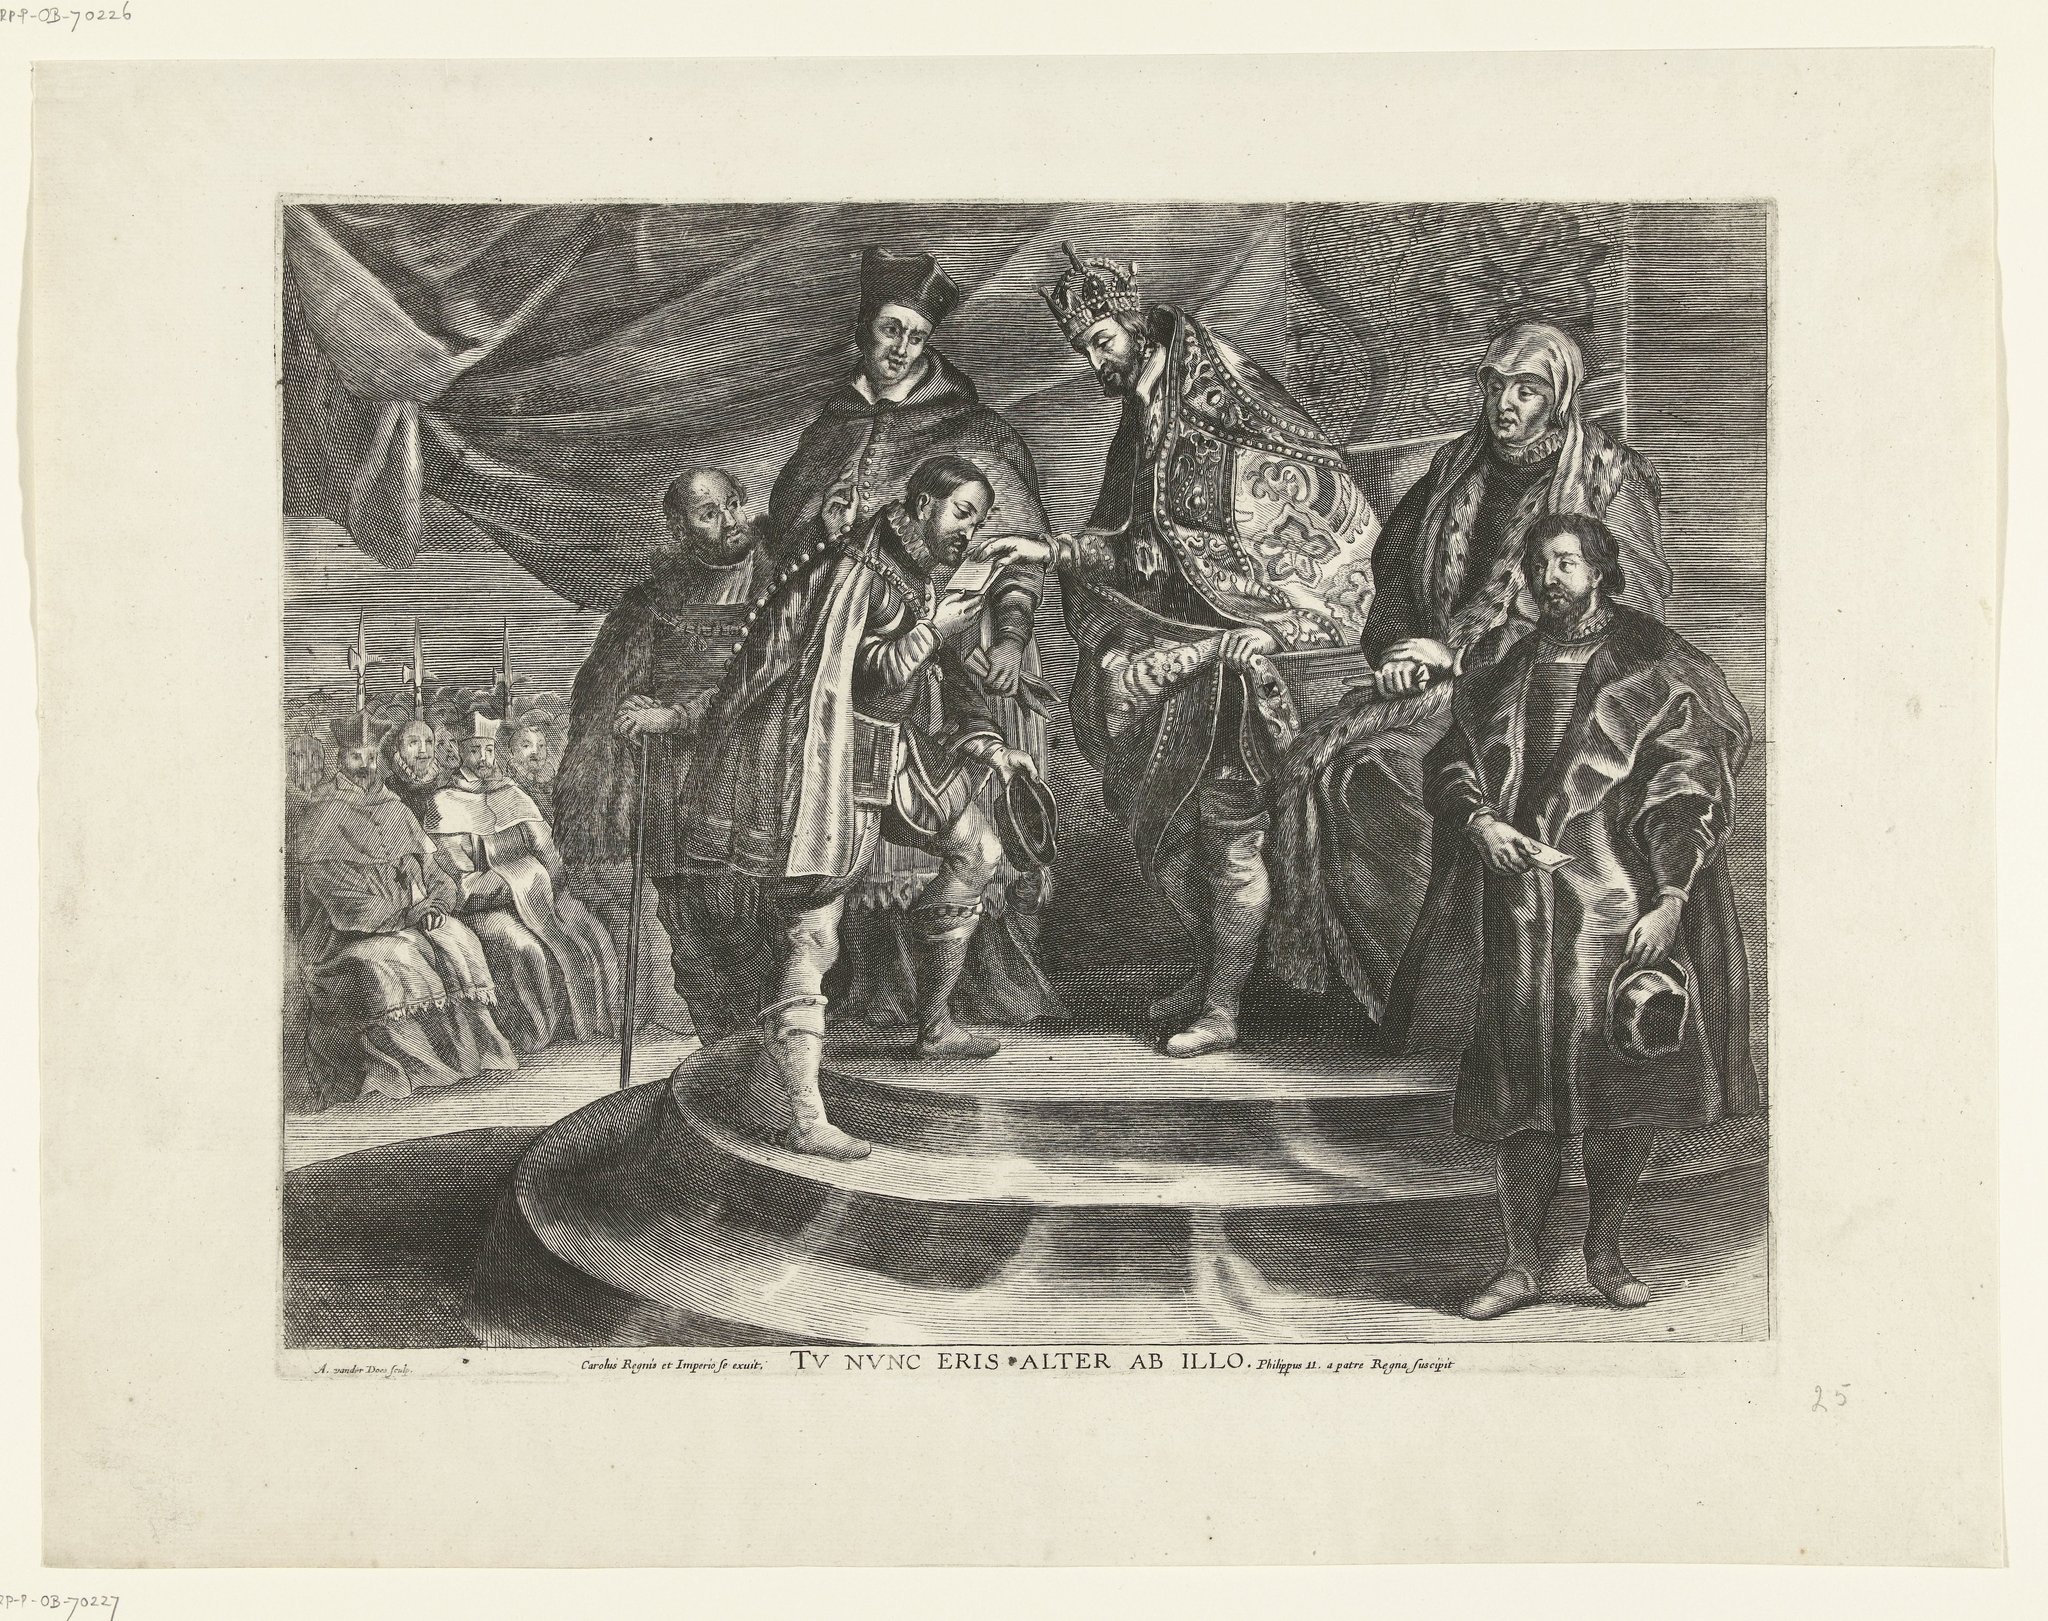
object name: print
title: Carolus regnis & imperio se exuit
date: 1635-1636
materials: paper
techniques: engraving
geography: southern netherlands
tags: philip ii of spain, antoine perrenot de granvelle, charles v (holy roman emperor and king of spain), brussels, maria van hongarije (landvoogdes der nederlanden), clergyman, landvoogd der zuidelijke nederlanden ferdinand van oostenrijk, triumphal arch, voluntary abdication (of a ruler), ghent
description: Troonsafstand van keizer Karel V op 25 oktober 1555, waarin hij de regering van de Nederlanden overdraagt aan zijn zoon Filips. De keizer staande voor de troon, naast hem zit zijn zuster Maria van Hongarije. Verder aanwezig: Viglius van Aytta en kardinaal Granvelle. Filips II kust de hand van zijn vader. Voorstelling op een zijwand van de doorgang van de triomfpoort Arcus Caroli op de Vrijdagmarkt. Blad nr. 25 in een geheel van 42 platen die de uitgave van de beschrijving van de intocht van de Kardinaal Infant Ferdinand van Oostenrijk te Gent op 28 januari 1635 als de nieuwe landvoogd voor de Spaanse Nederlanden illustreren.